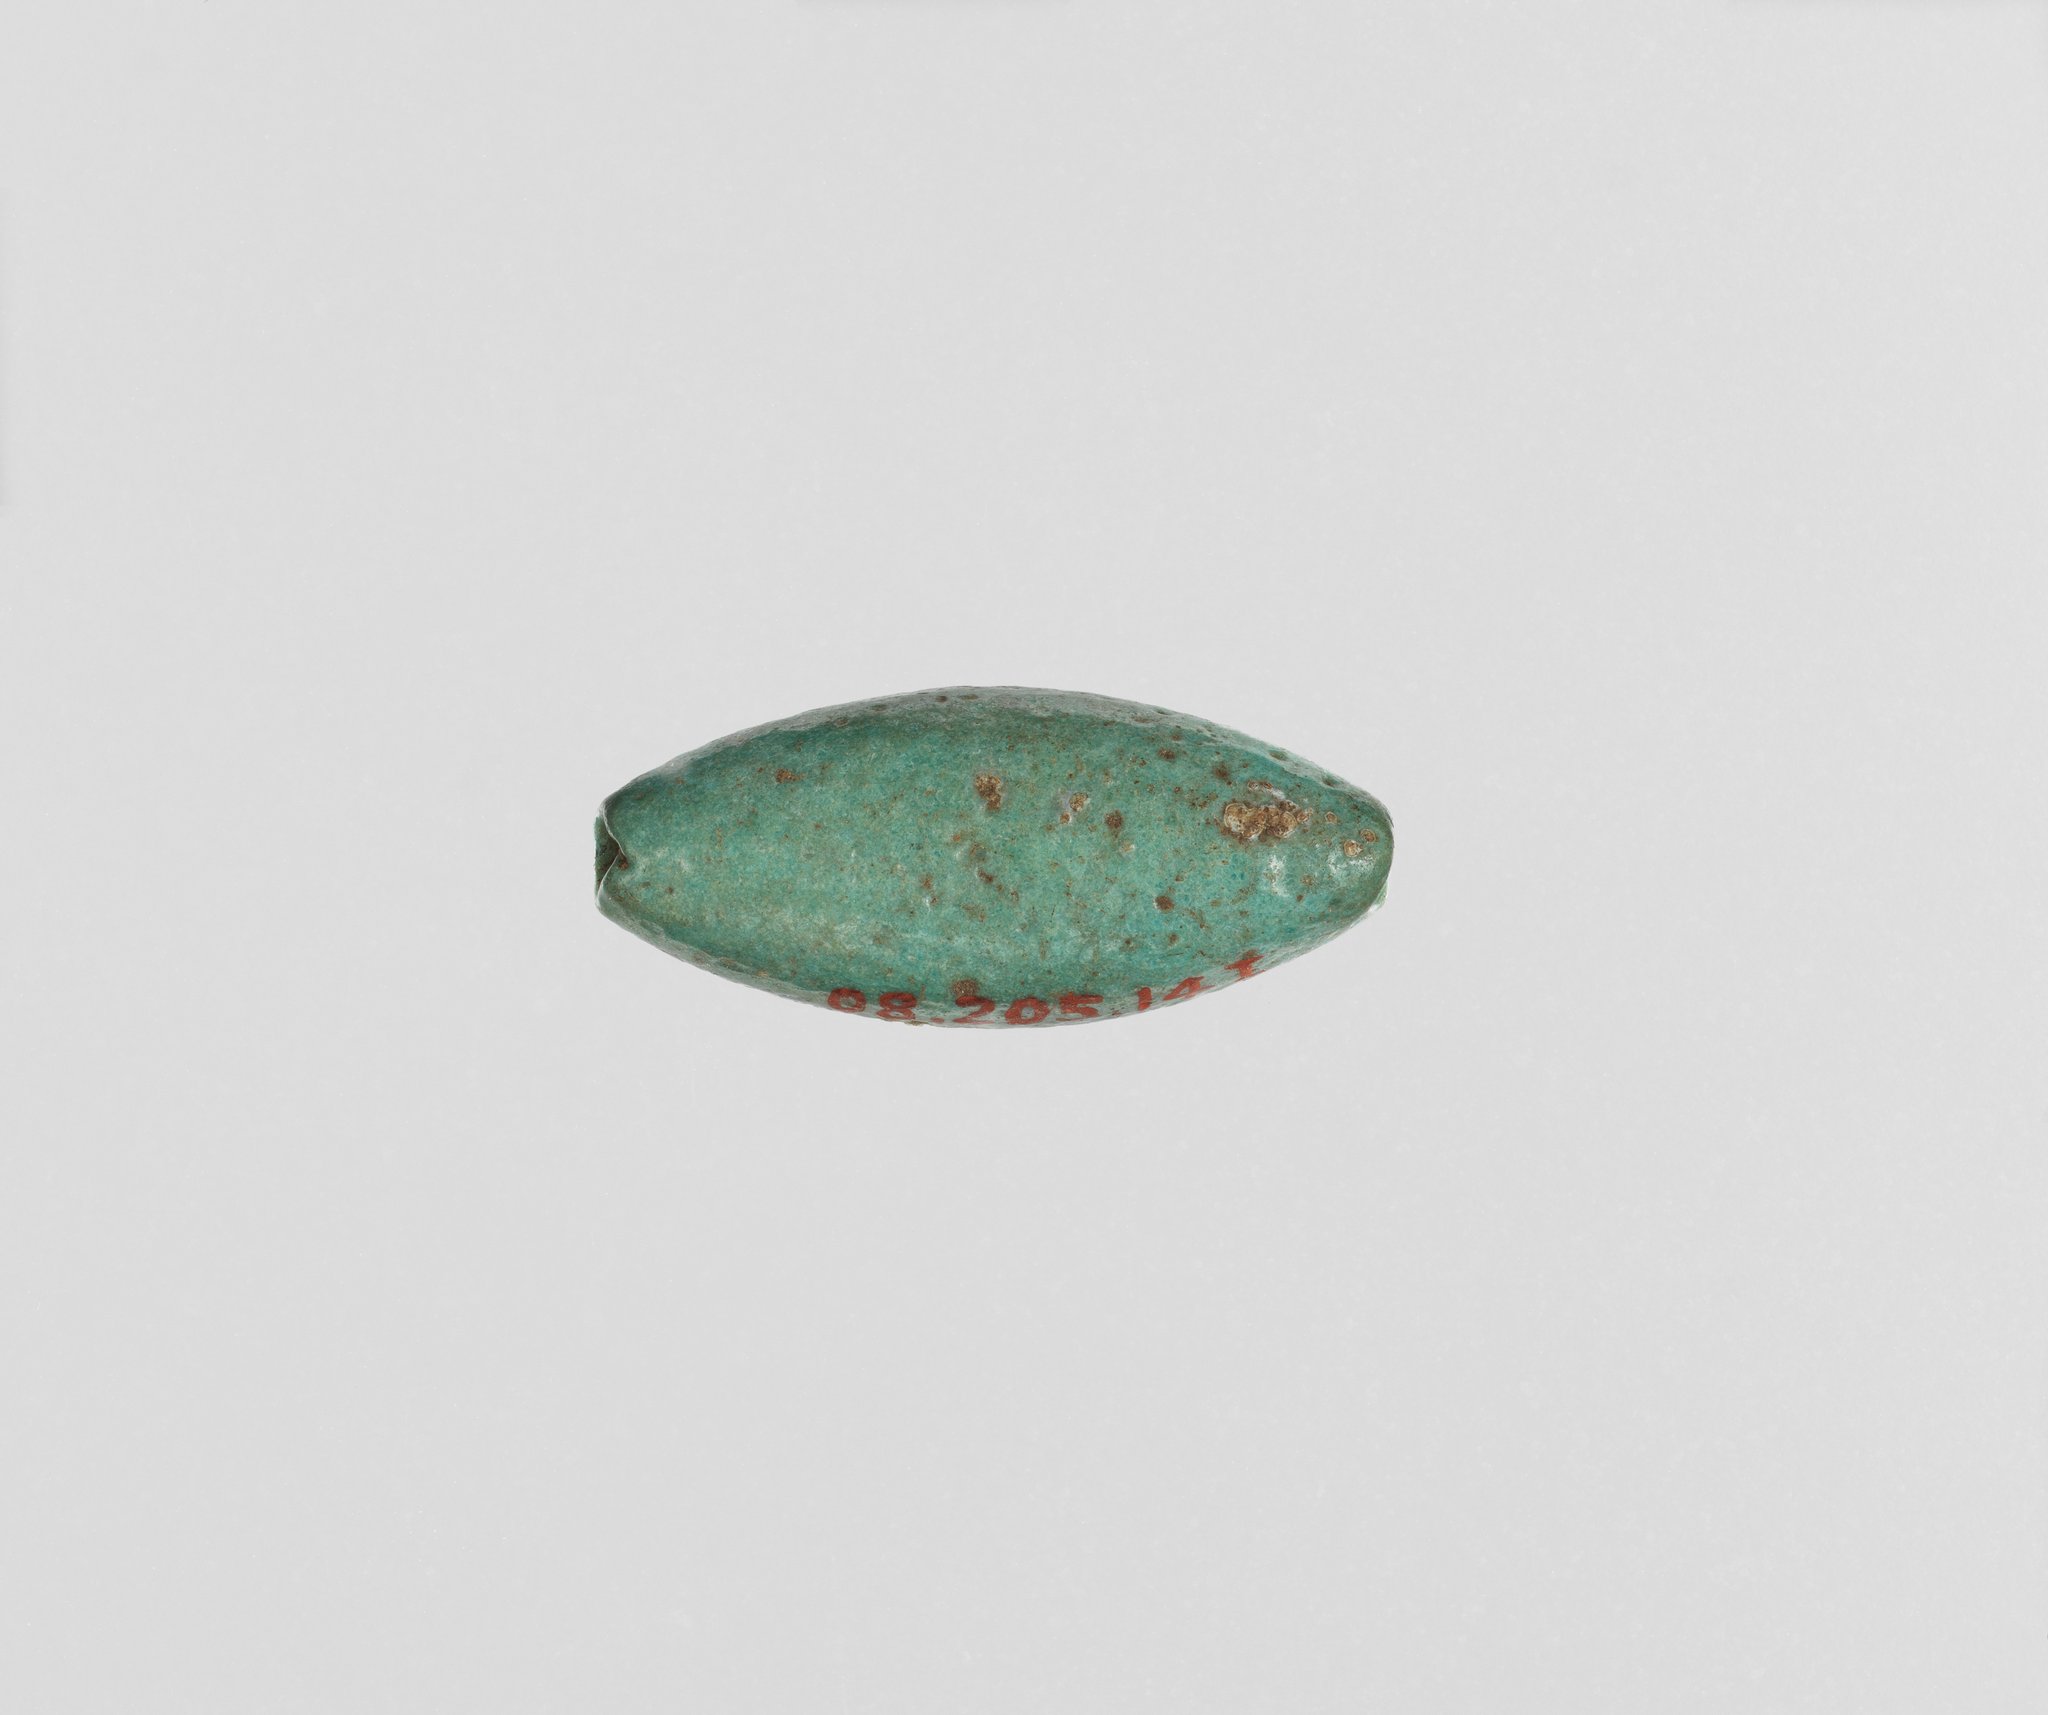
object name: bead, oblong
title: Oblong bead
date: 1550-1295 BCE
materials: faience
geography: egypt